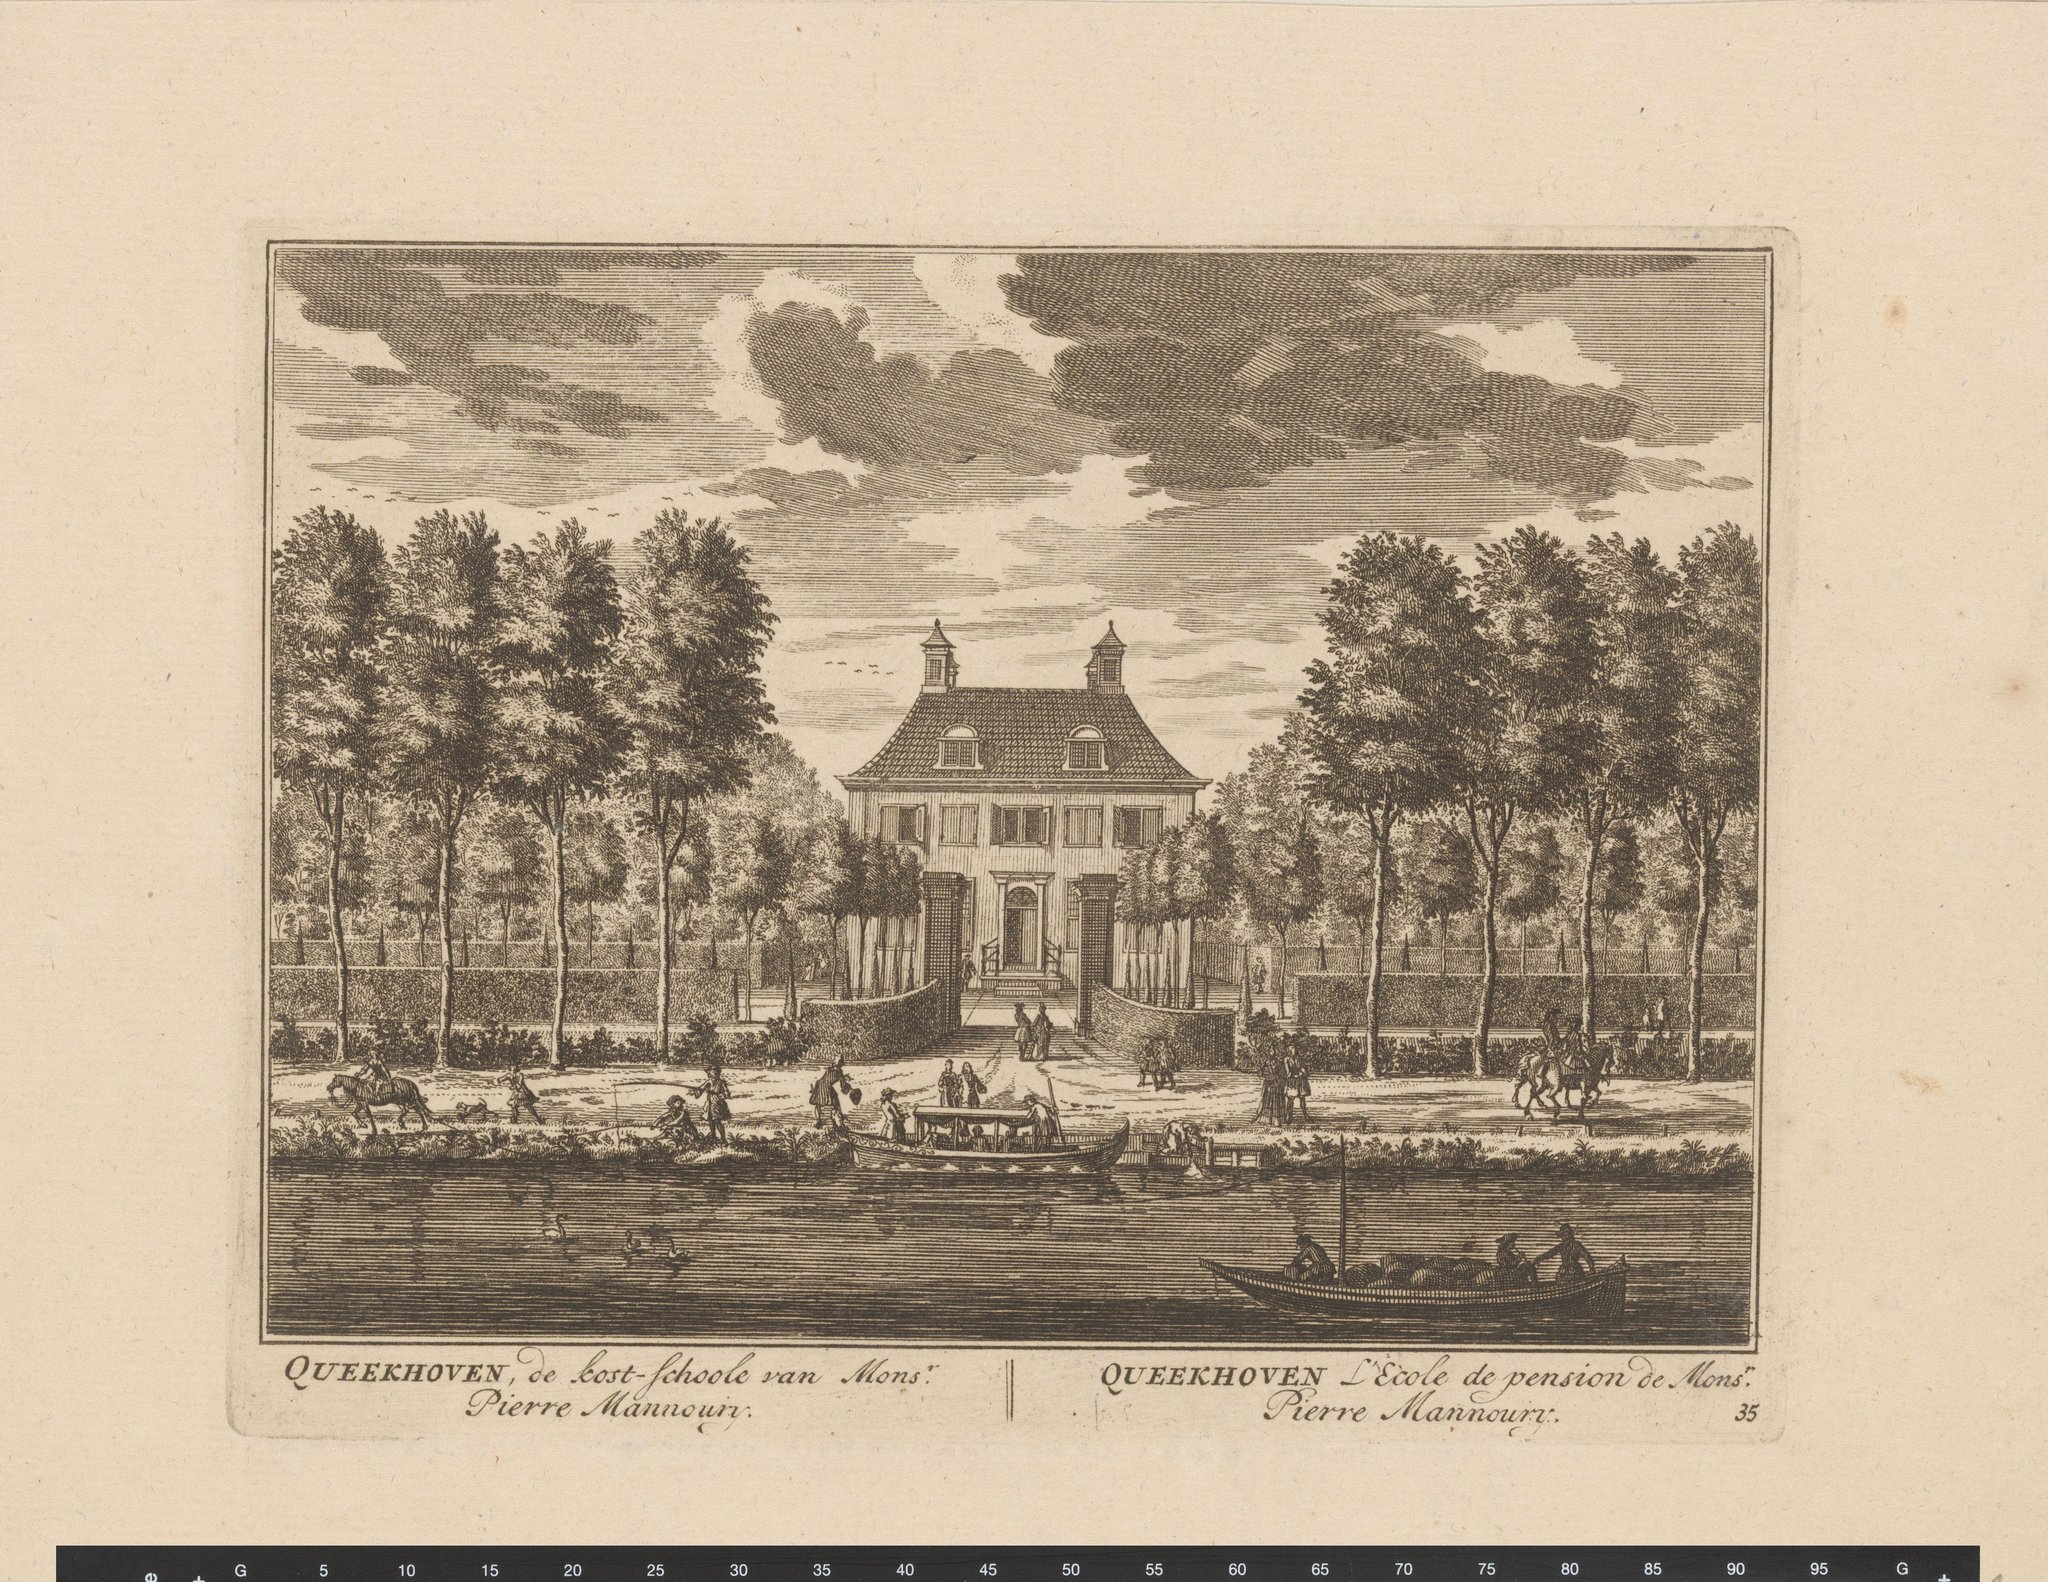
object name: print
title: Gezicht op buitenplaats Queekhoven in Breukelen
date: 1719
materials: paper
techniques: etching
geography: amsterdam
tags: rural housing, e.g. country-house, villa, cottage, landscape with tower or castle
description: Prent uit: Stopendaal, Daniël. De zegepraalende Vecht, vertoonende verscheidenen gesichten van lustplaatsen, heeren huysen en dorpen, beginnende van Uitrecht en met Muyden besluytende. Amsterdam: Weduwe Nicolaas Visscher, 1719.